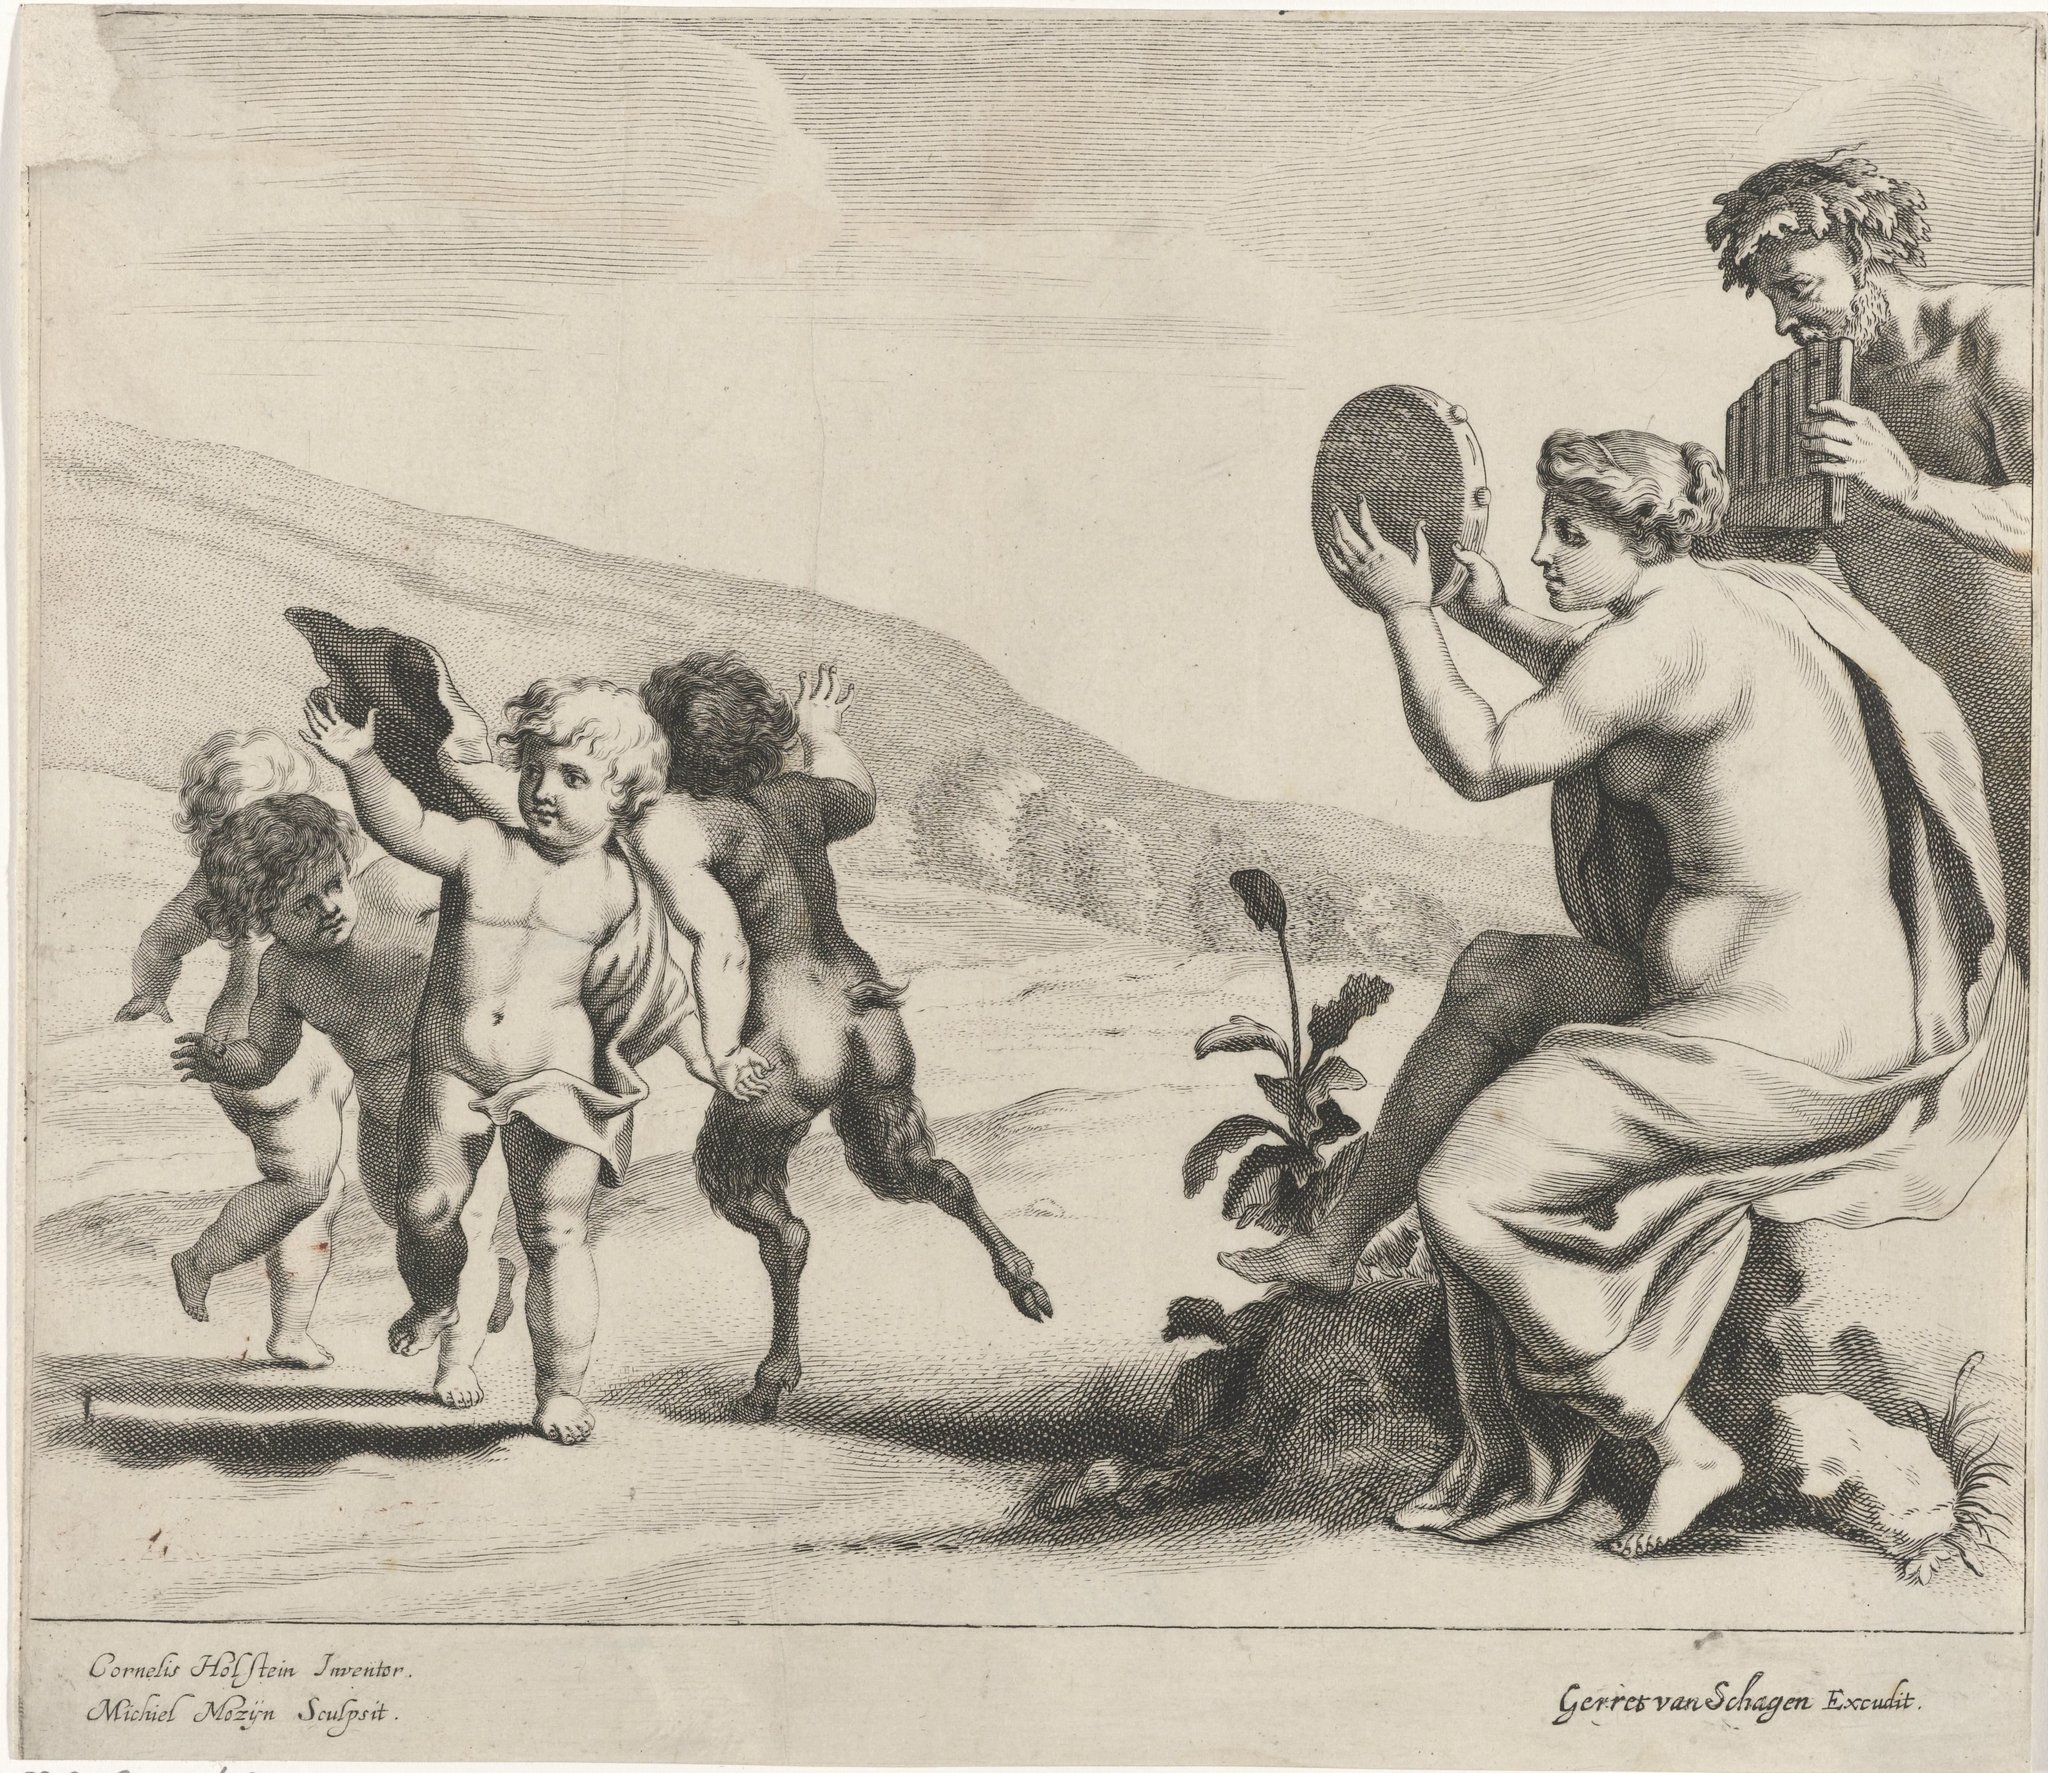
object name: print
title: Dansende kinderen voor sater en maenade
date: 1640-1655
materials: paper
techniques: engraving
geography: netherlands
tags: panpipes, tambourine, maenad(s), female bacchant(es), satyr(s) (in general), group dancing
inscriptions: collector's mark: Lugt 240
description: Een groep kinderen, onder wie een sater, danst in een kring. Rechts bespeelt een maenade de tamboerijn en een sater speelt op de panfluit.